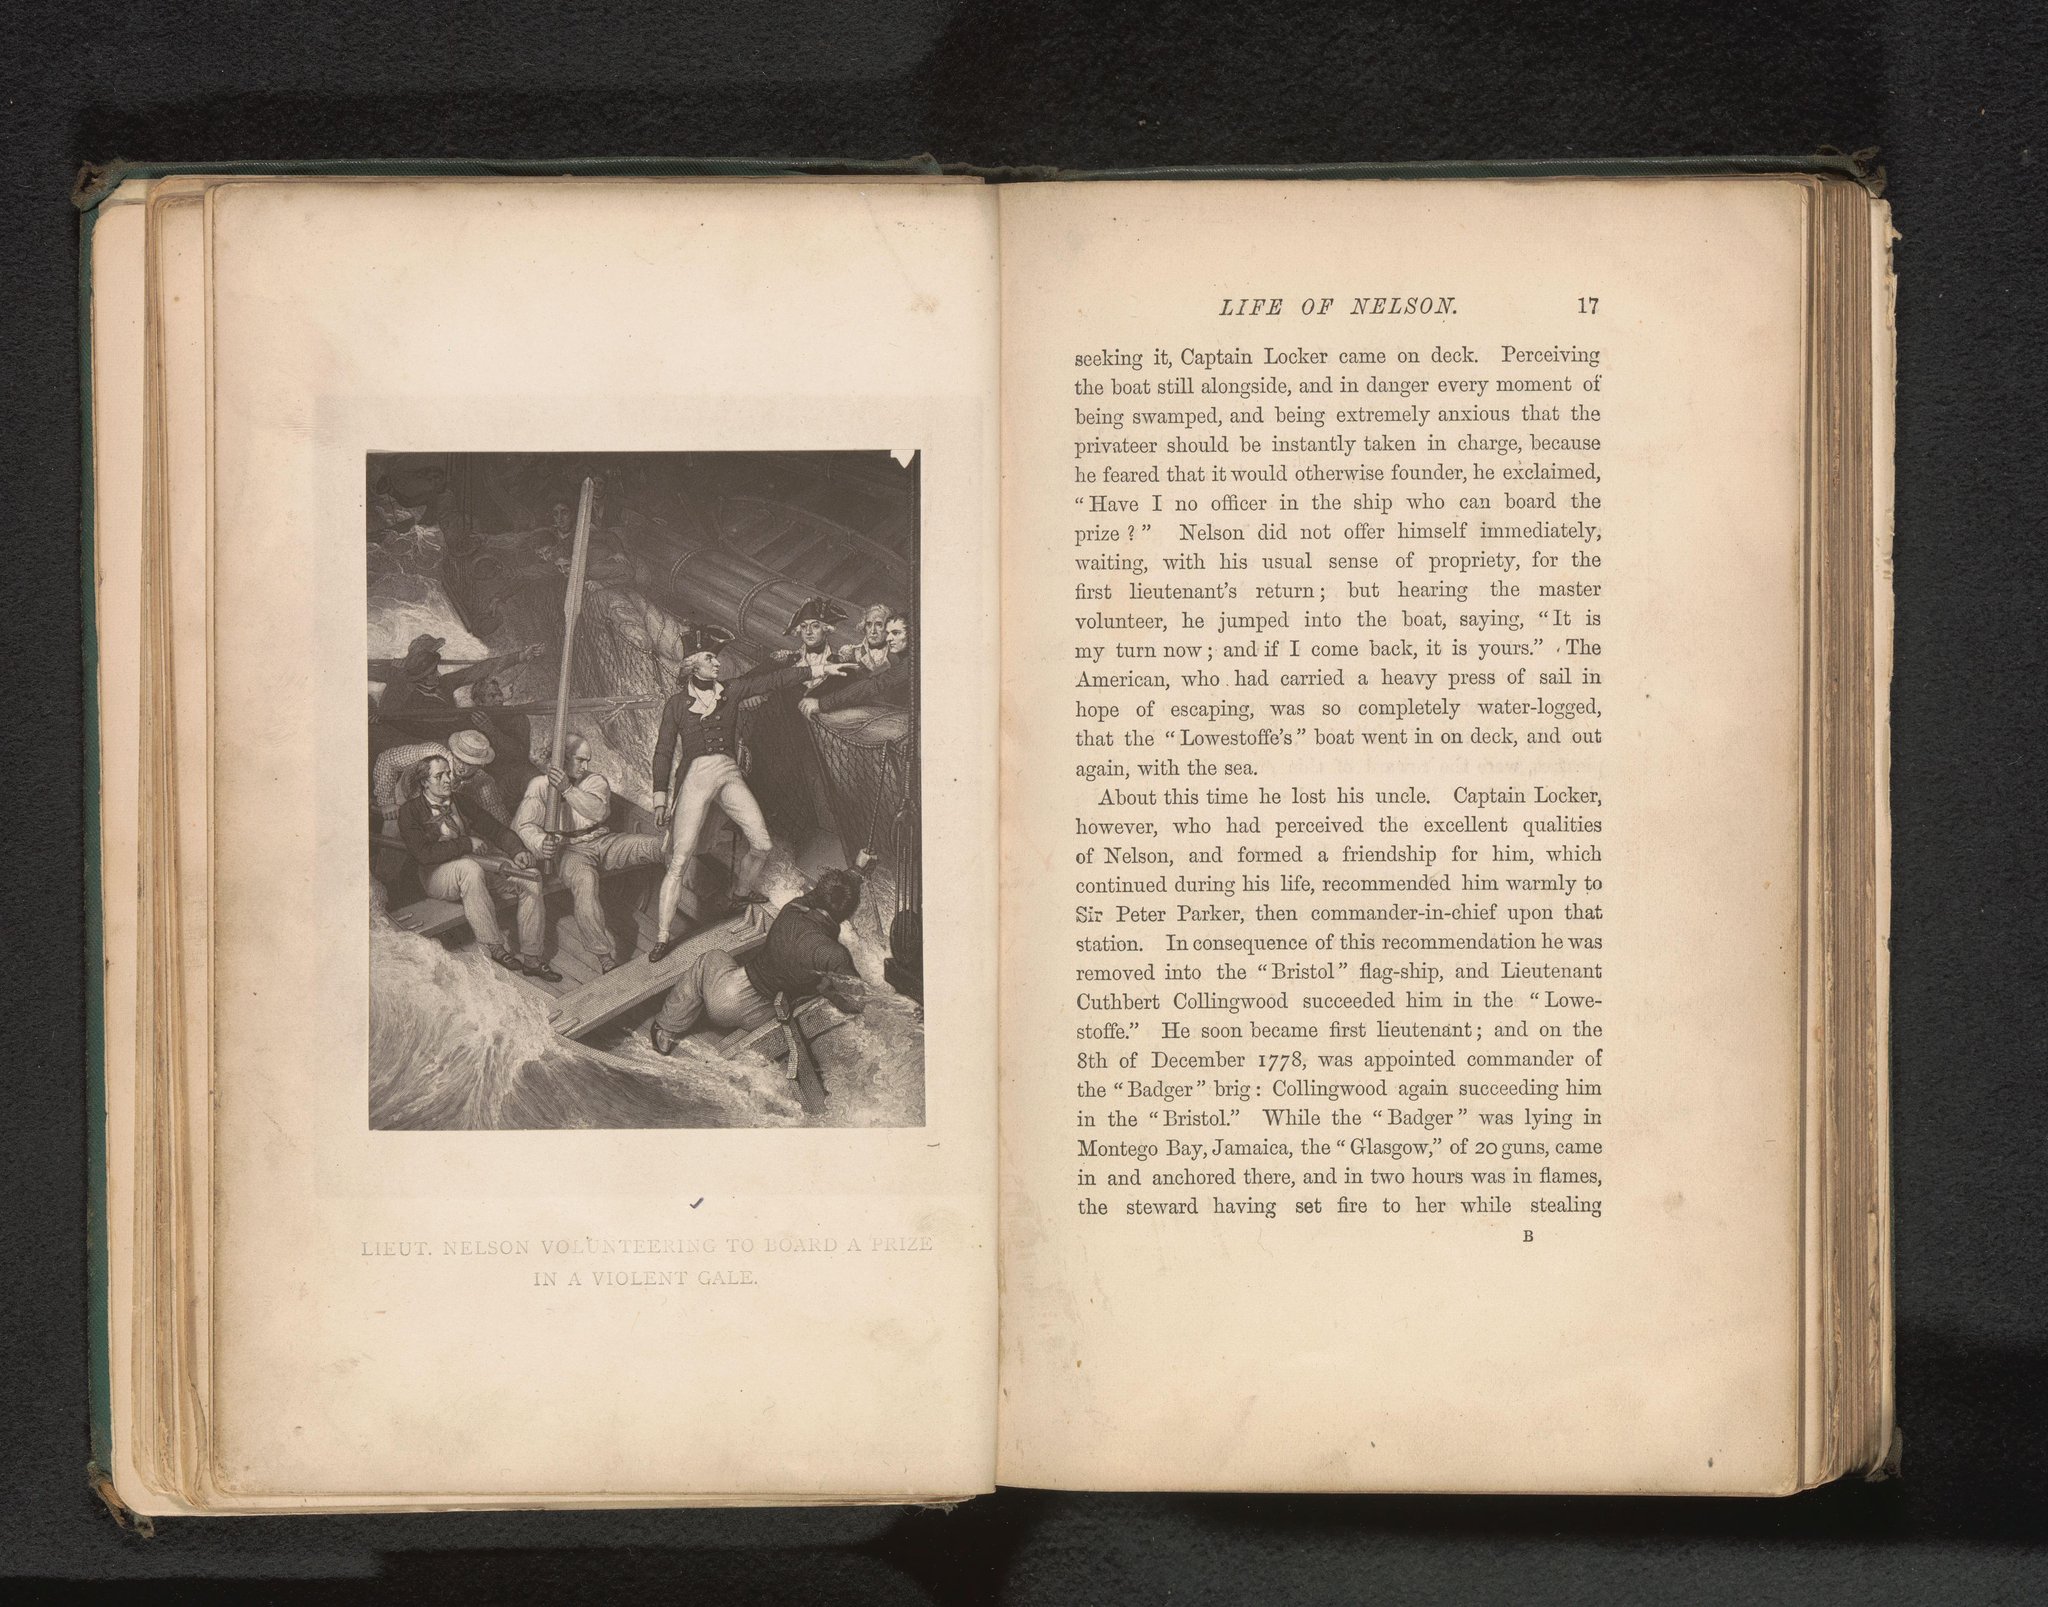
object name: photomechanical print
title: Lieut. Nelson Volunteering to Board a Prize in a Violent Gale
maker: Anonymous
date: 1877-1887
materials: paper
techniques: woodburytype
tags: horatio nelson (hertog van bronte), storm at sea